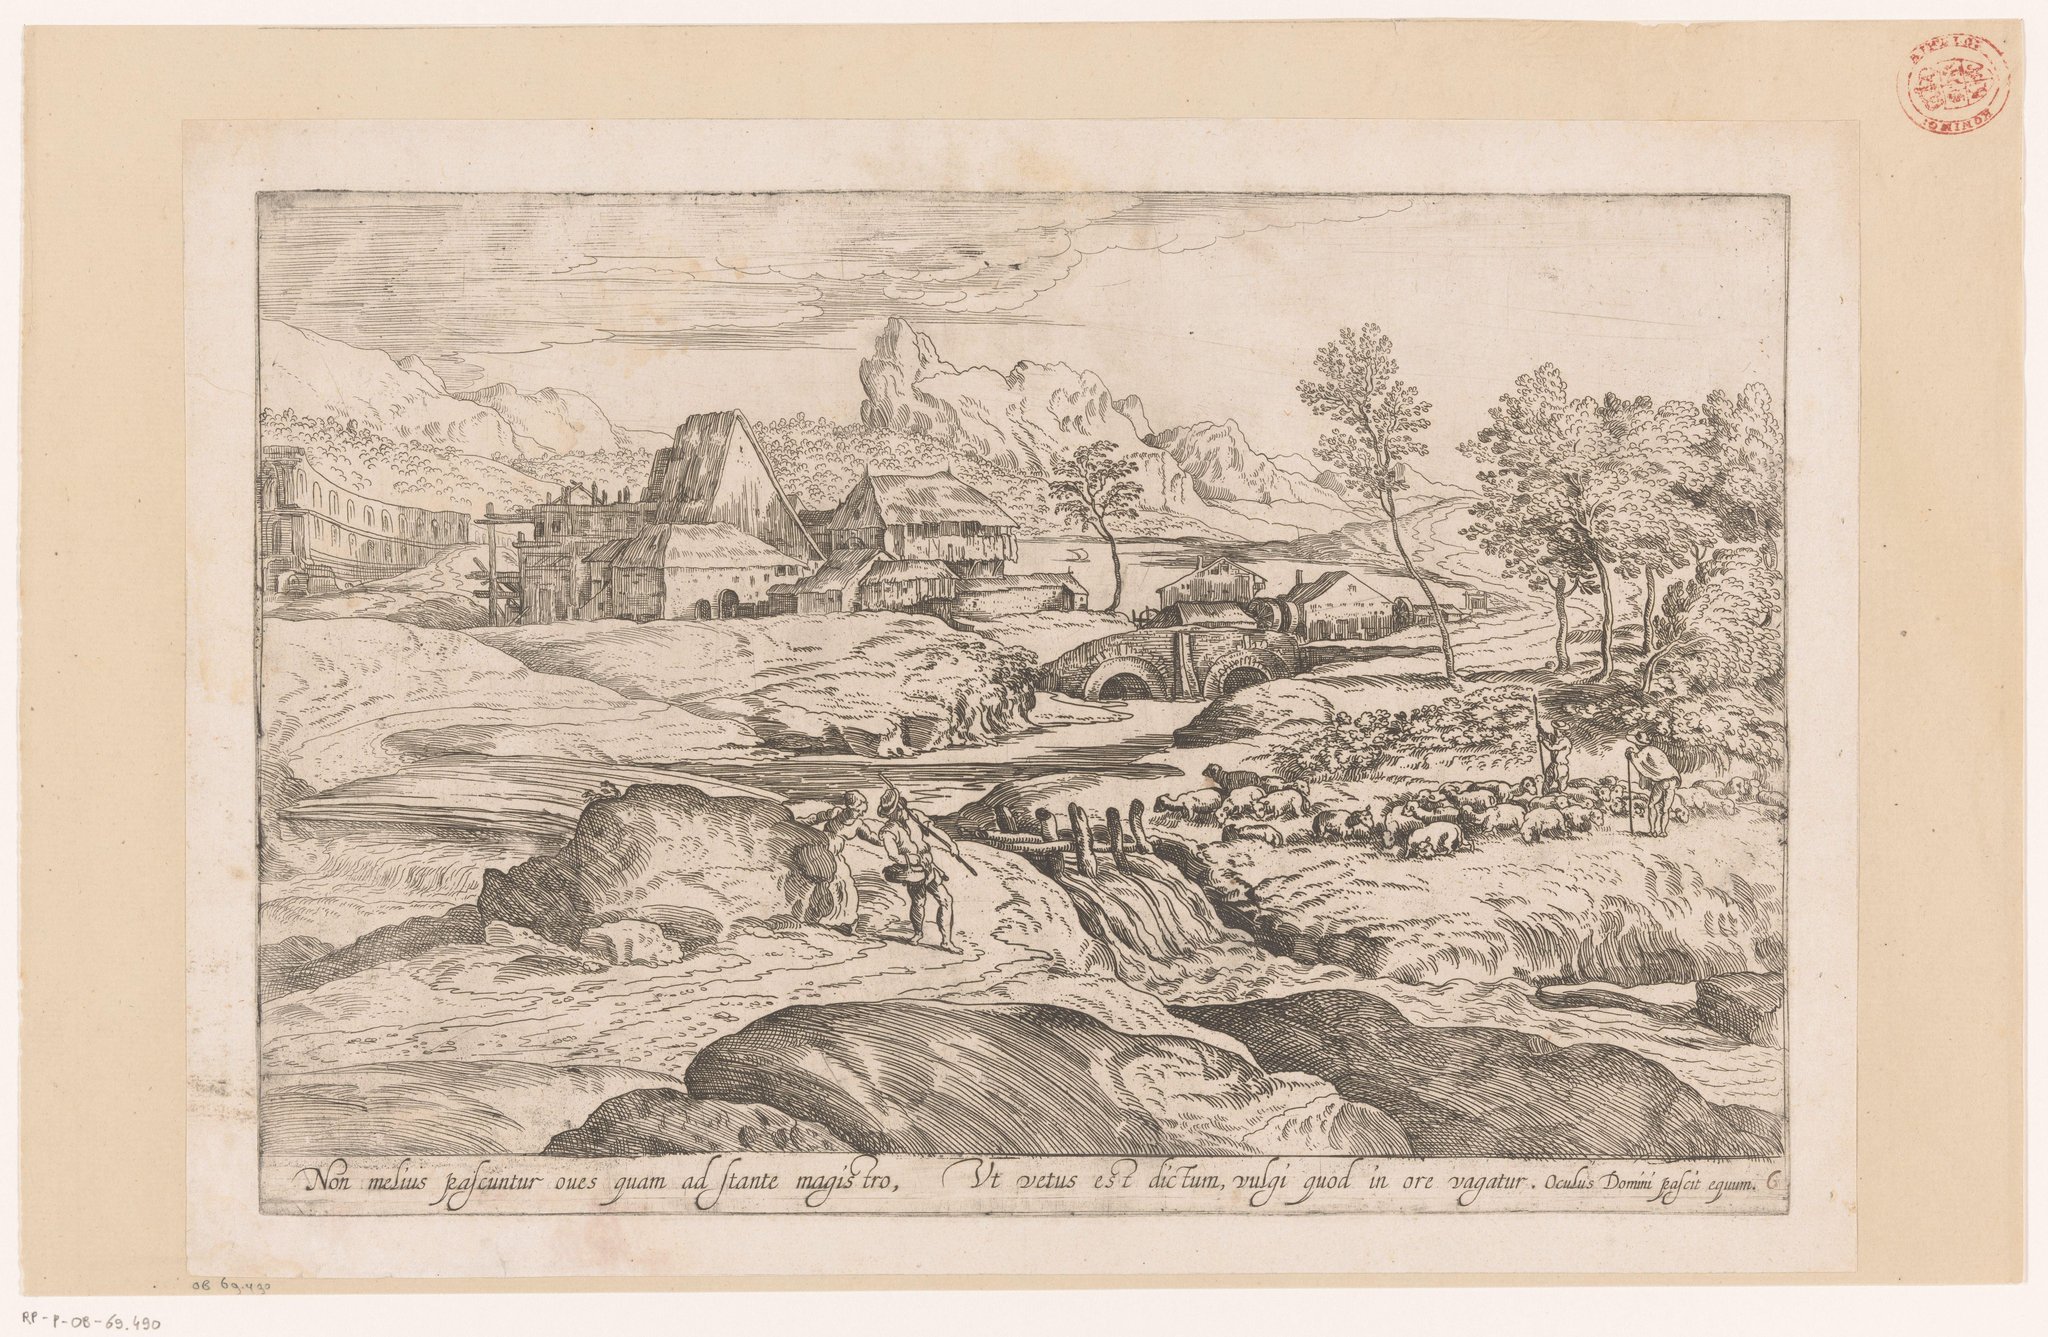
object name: print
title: Landschappen naar Campagnola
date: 1634-1679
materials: paper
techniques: etching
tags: rapids, herding, herdsman, herdswoman, shepherd, shepherdess, cowherd, etc., landscapes in the temperate zone, sheep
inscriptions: number: ‘6’, collector's mark: Lugt 240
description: Maakt deel uit van een 24-delige serie naar tekeningen van landschappen toegeschreven aan Campagnola, of de school van Campagnola (zie British Museum, inv.nr. S.6782). Plaat twee uit de serie betreft waarschijnlijk echter een ontwerp van Titaan (zie British Museum, inv.nr. S.6783).